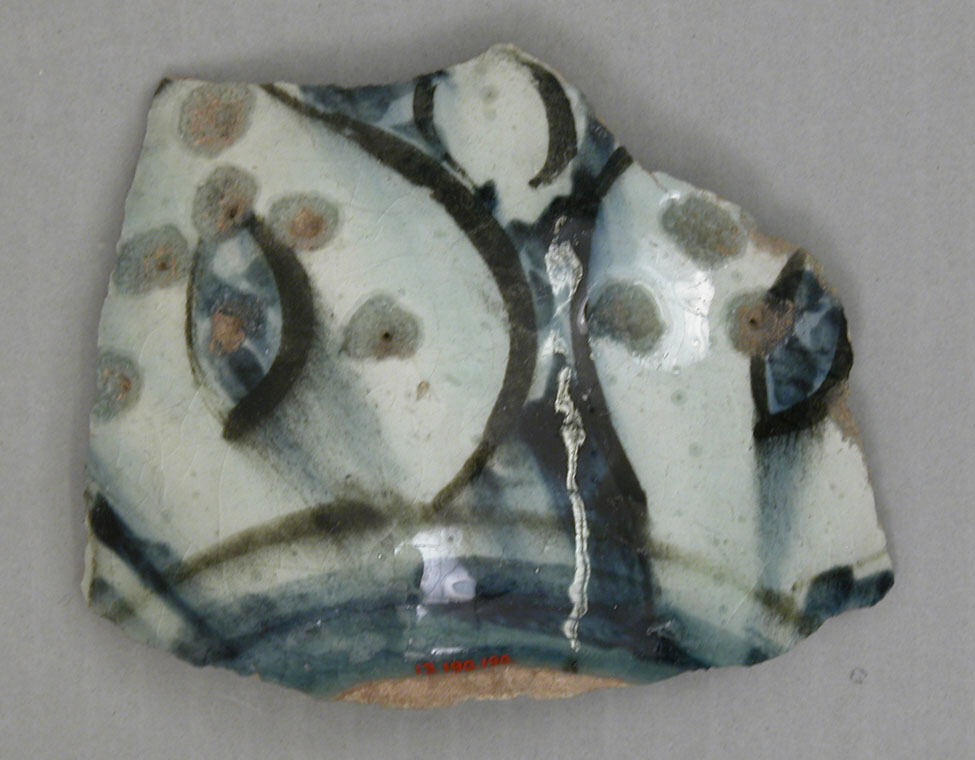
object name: ceramic fragment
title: Fragment of Dish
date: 1301-1500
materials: glaze, stonepaste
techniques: painting, polychrome, underglaze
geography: syria